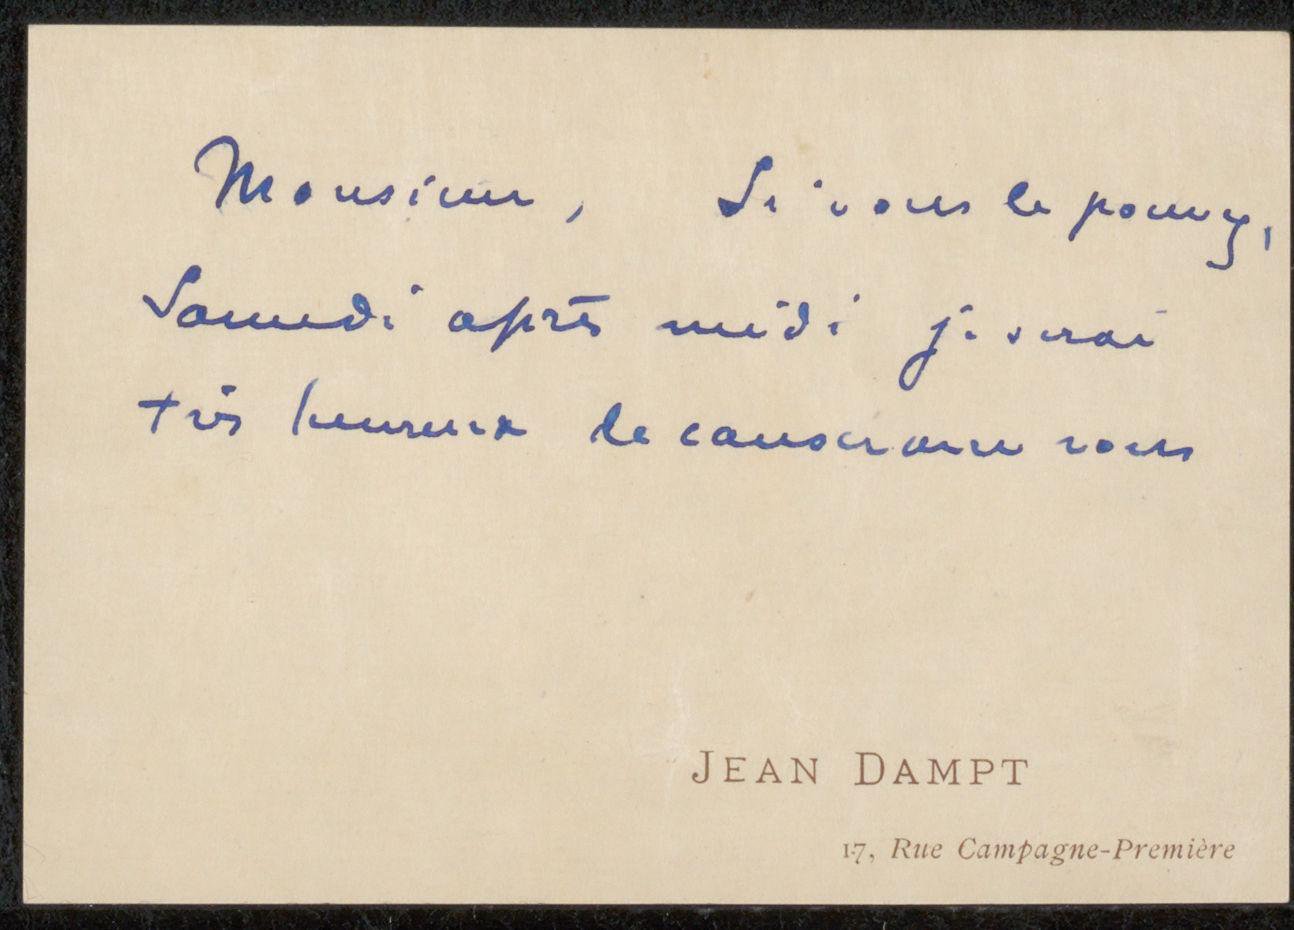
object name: visiting card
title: Visitekaartje aan Philip Zilcken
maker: dampt. jean baptiste august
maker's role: sculptor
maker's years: 1854-1945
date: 1864-1945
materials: ink, paper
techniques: pen, printing, writing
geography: paris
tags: the hague, painter, philip zilcken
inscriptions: collector's mark: ‘RPK’